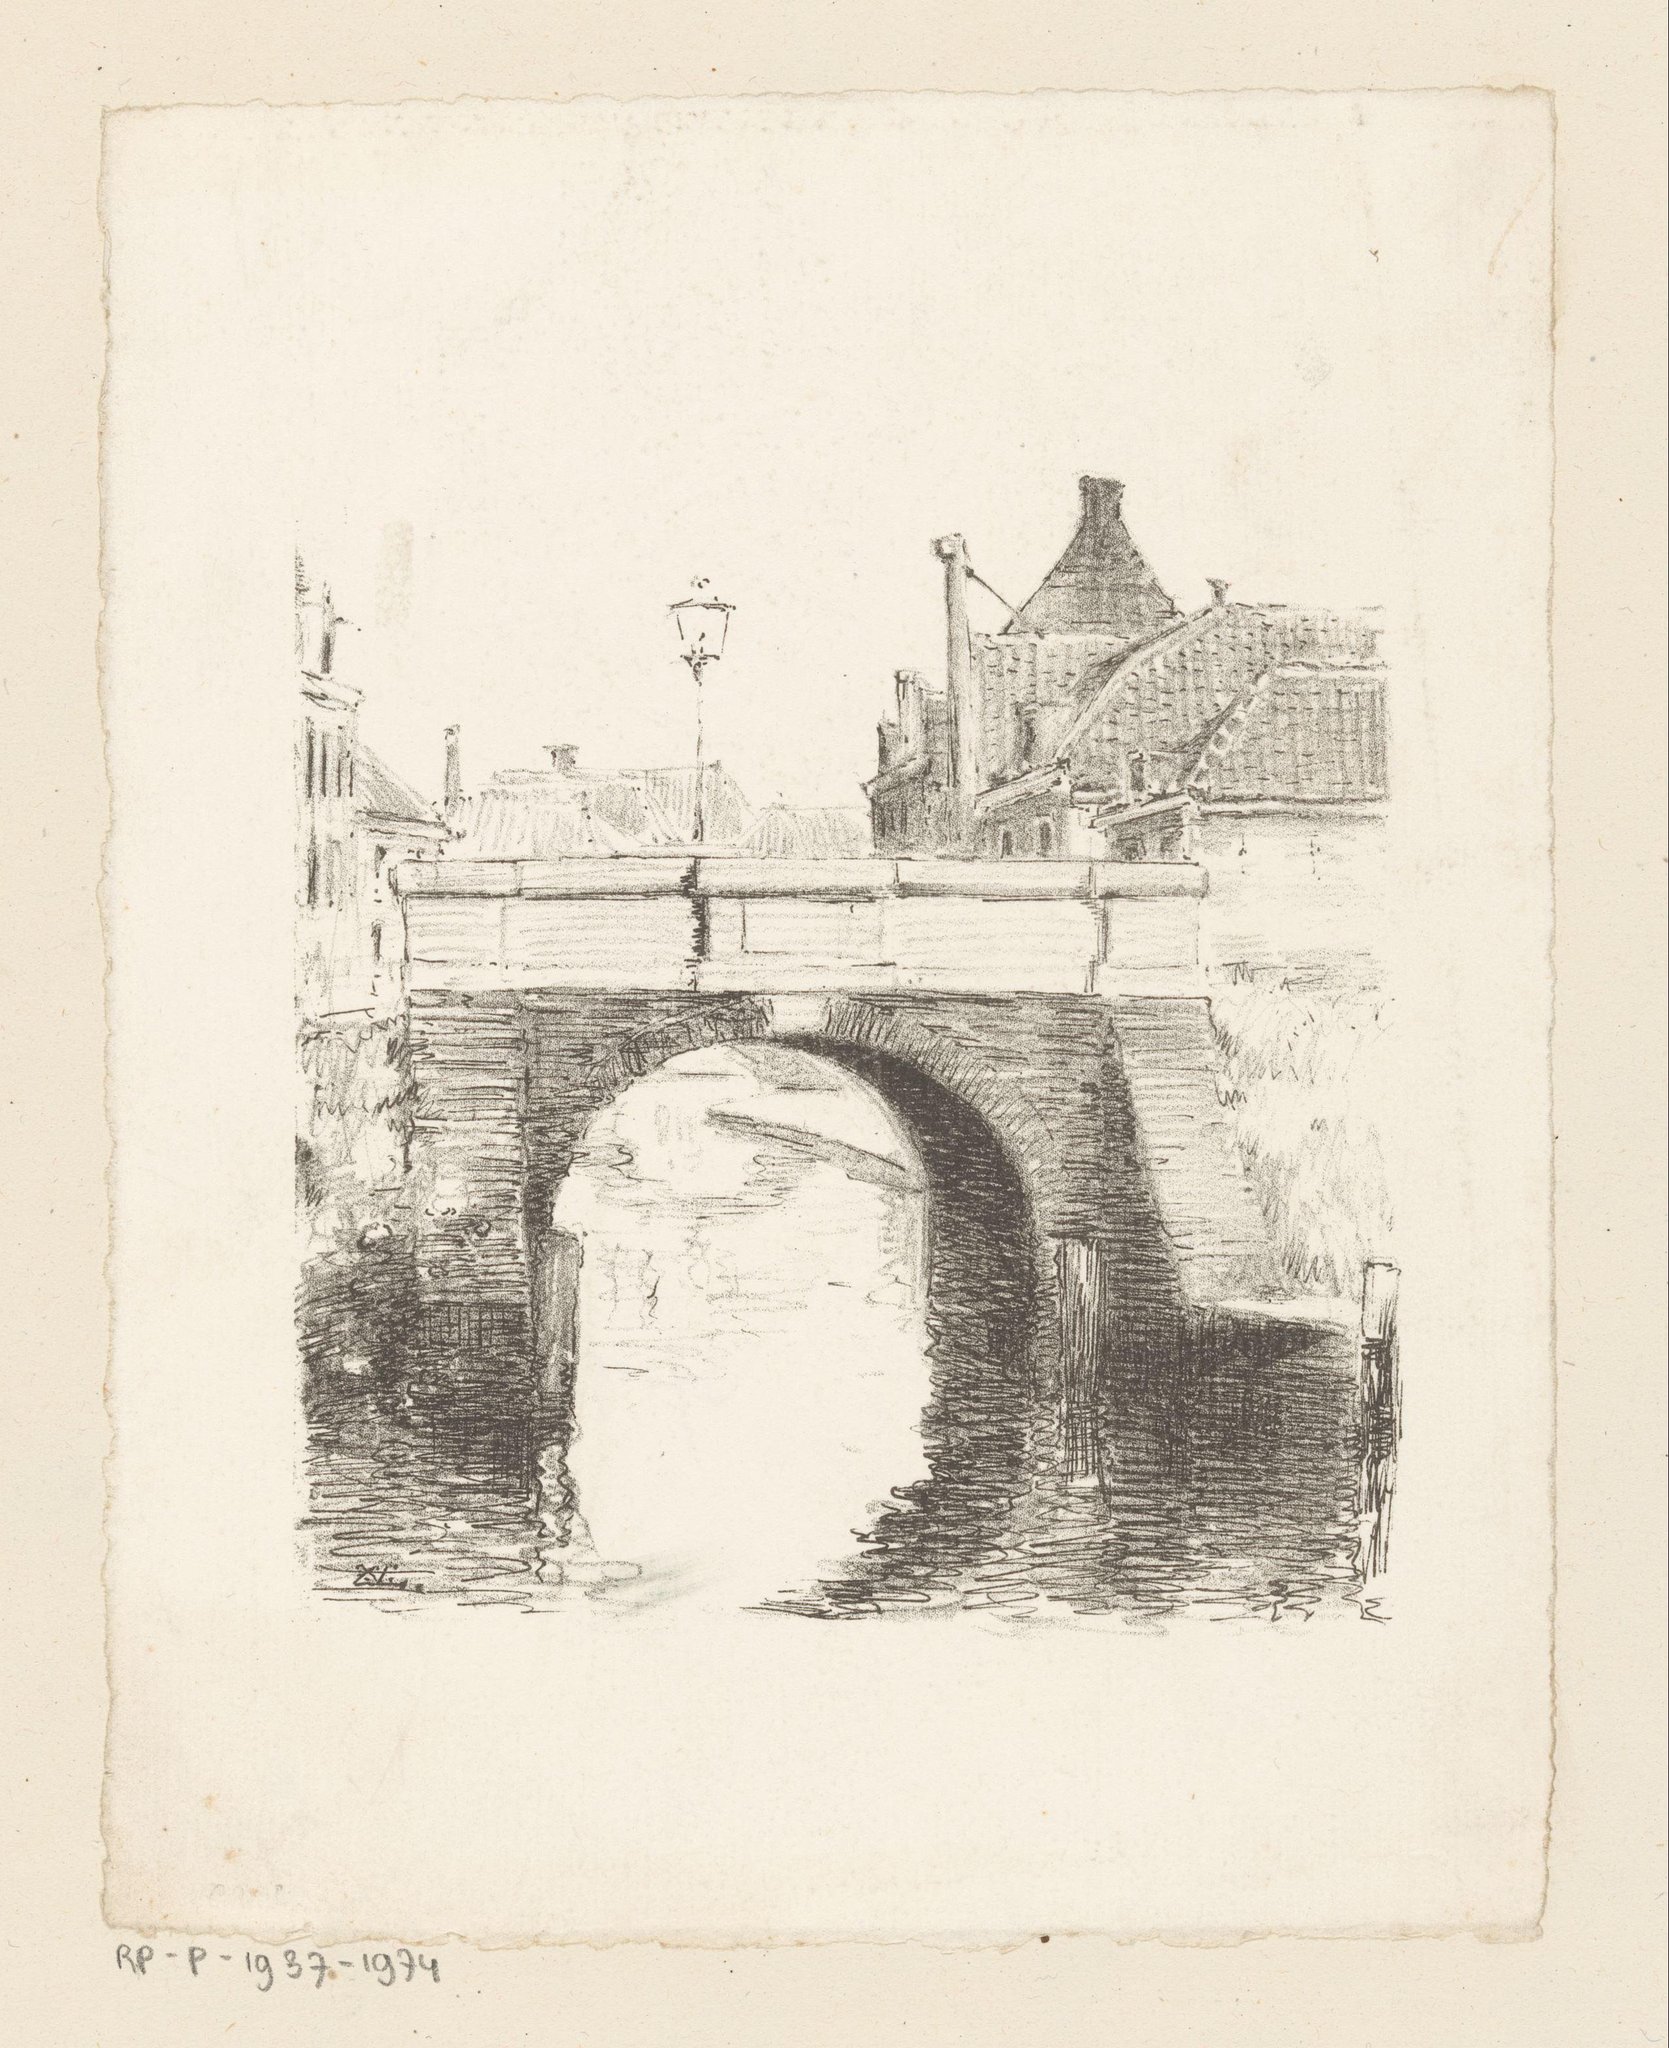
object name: print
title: Brug in een stad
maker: Anonymous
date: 1809-1899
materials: paper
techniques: lithograph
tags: bridge in city across river, canal, etc.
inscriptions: collector's mark: Lugt 2760, collector's mark: Lugt 2228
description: Op de brug staat een straatlantaarn. Linksonder in de afbeelding de signatuur van de prentmaker of ontwerper.